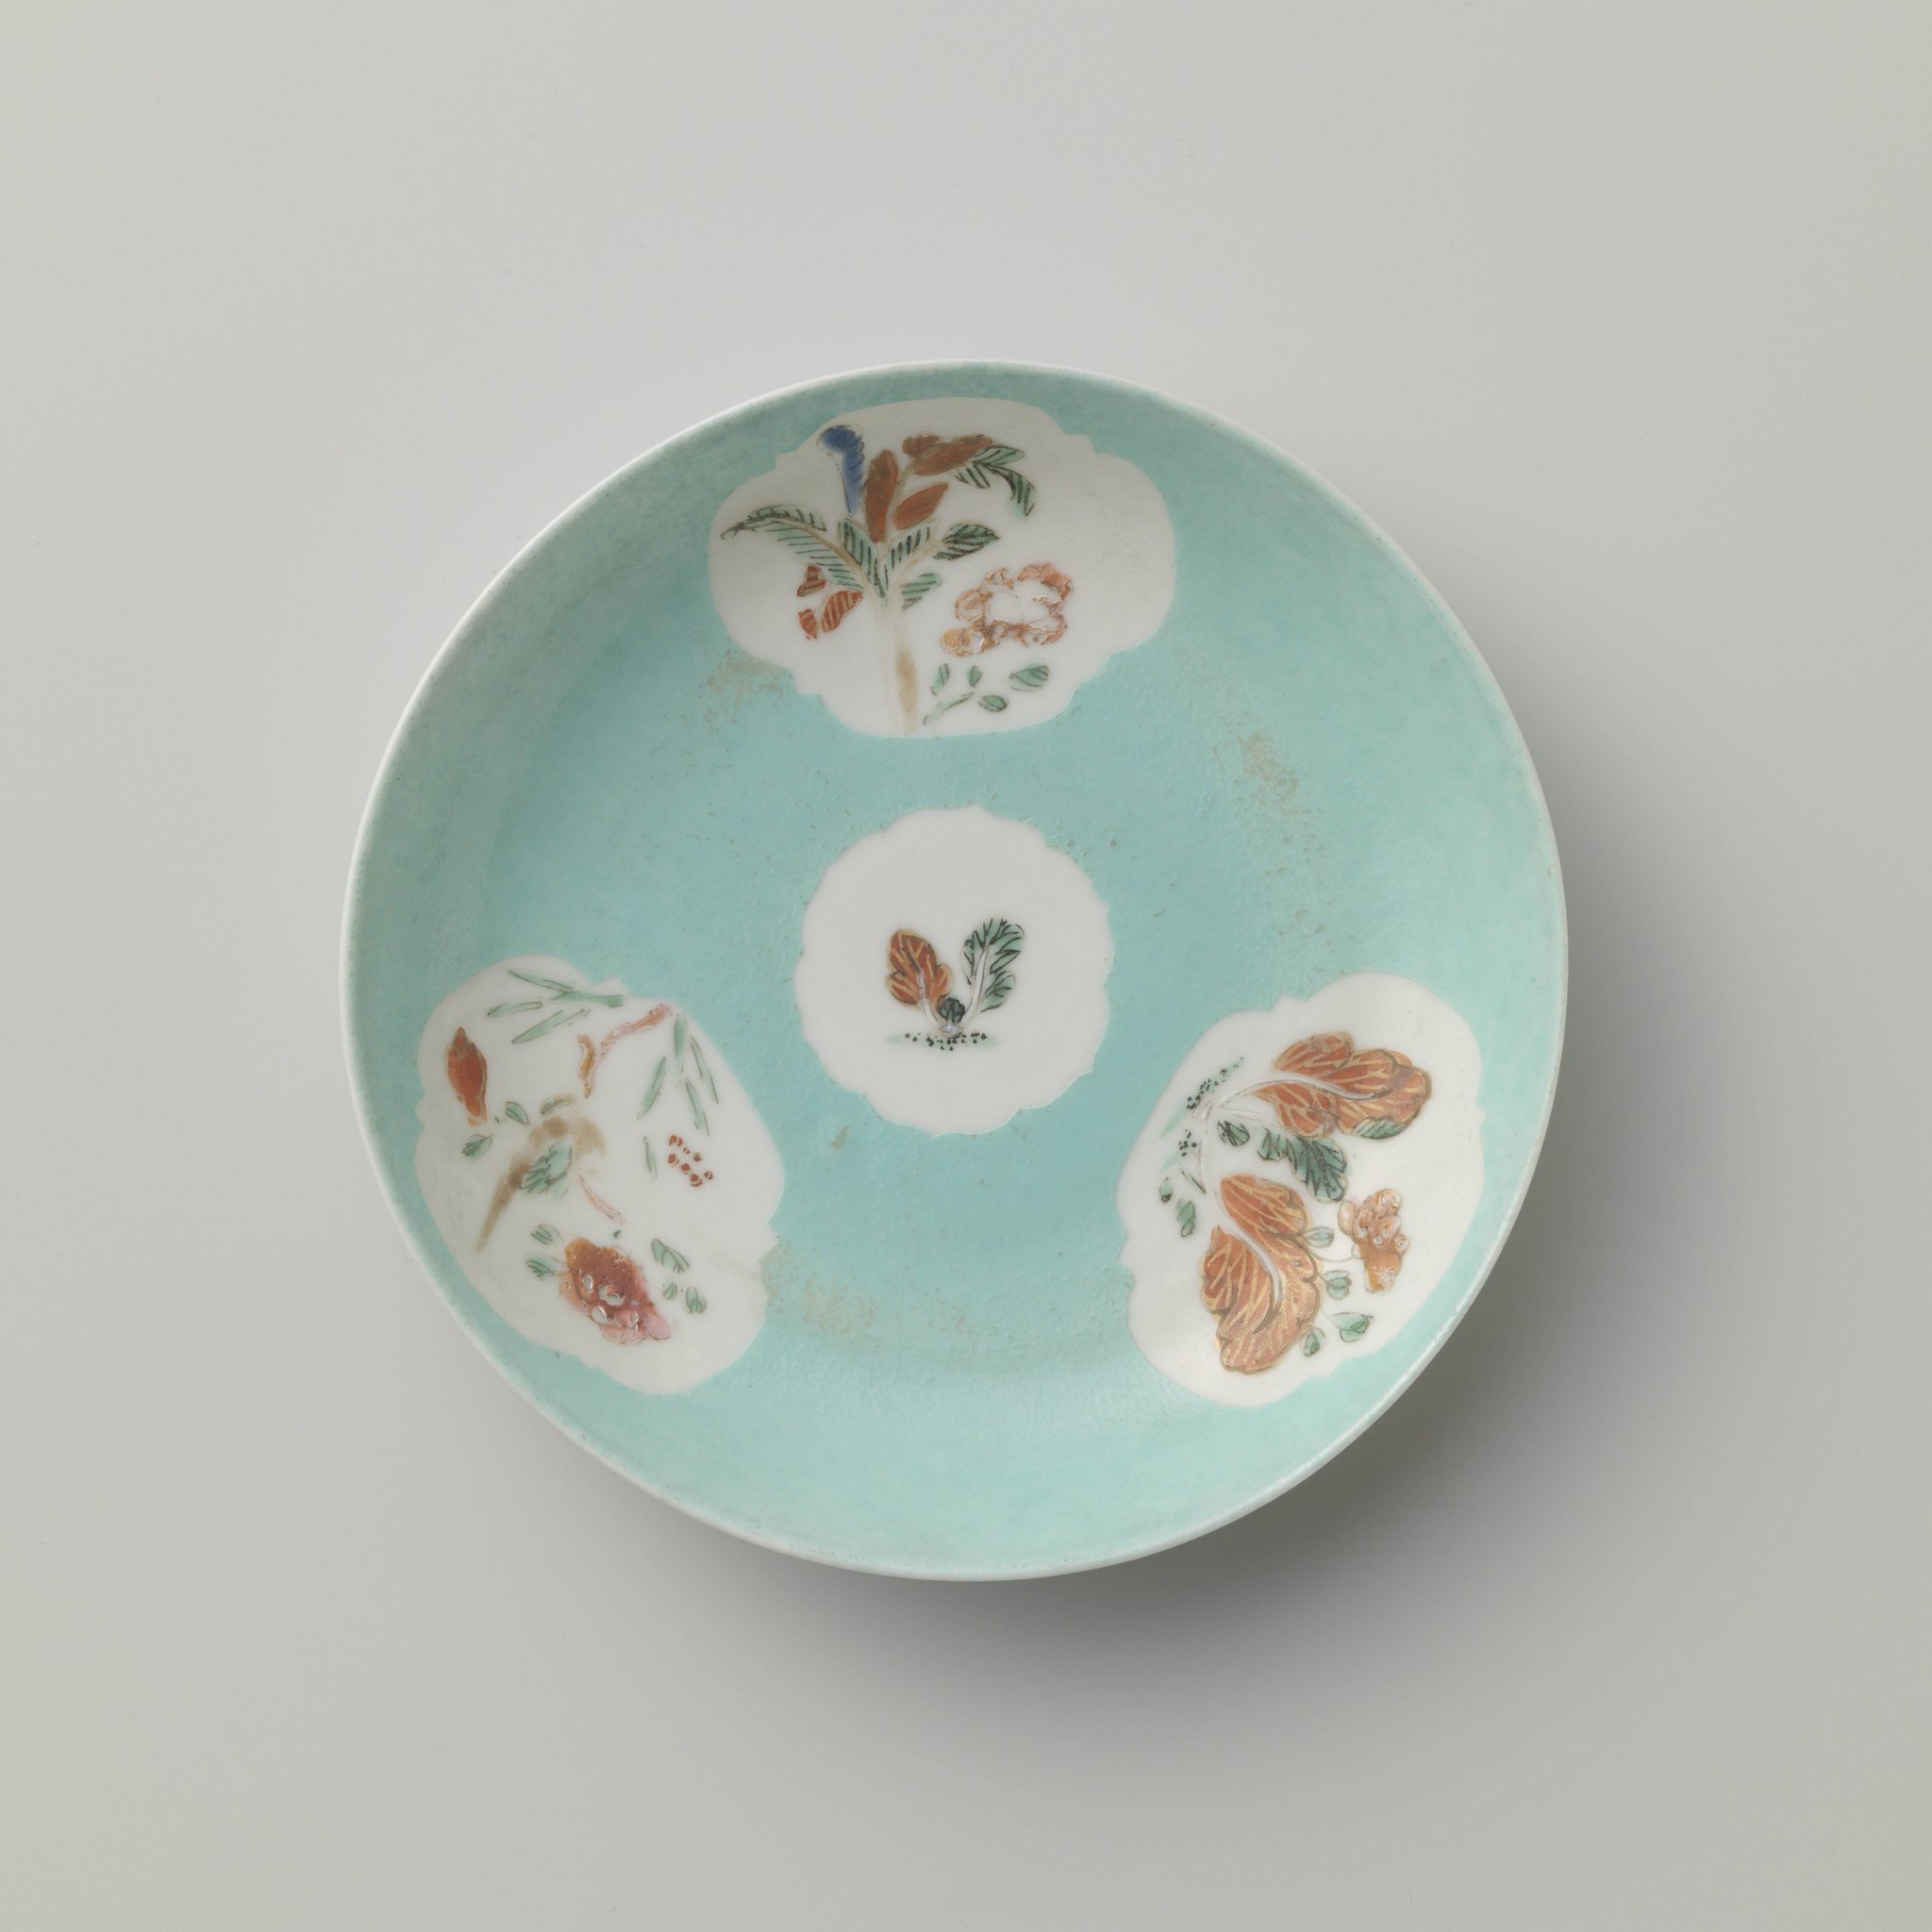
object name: platter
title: Saucer with flowering plants in shaped panels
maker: Anonymous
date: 1760-1780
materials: glaze, gold, paint, porcelain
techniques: firing, gilding, turning, vitrification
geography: china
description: Schotel van porselein, bedekt met een turquoise glazuur en berschilderd in blauw, rood, roze, groen, zwart en goud. De schotel is aan de voorzijde bedekt met een turquoise glazuur met hierin uitgespaard in het centrum een geschulpt medaillon met plant, daaromheen drie uitgespaarde cartouches met bloeiende planten en een vogel op een tak. Famille rose.